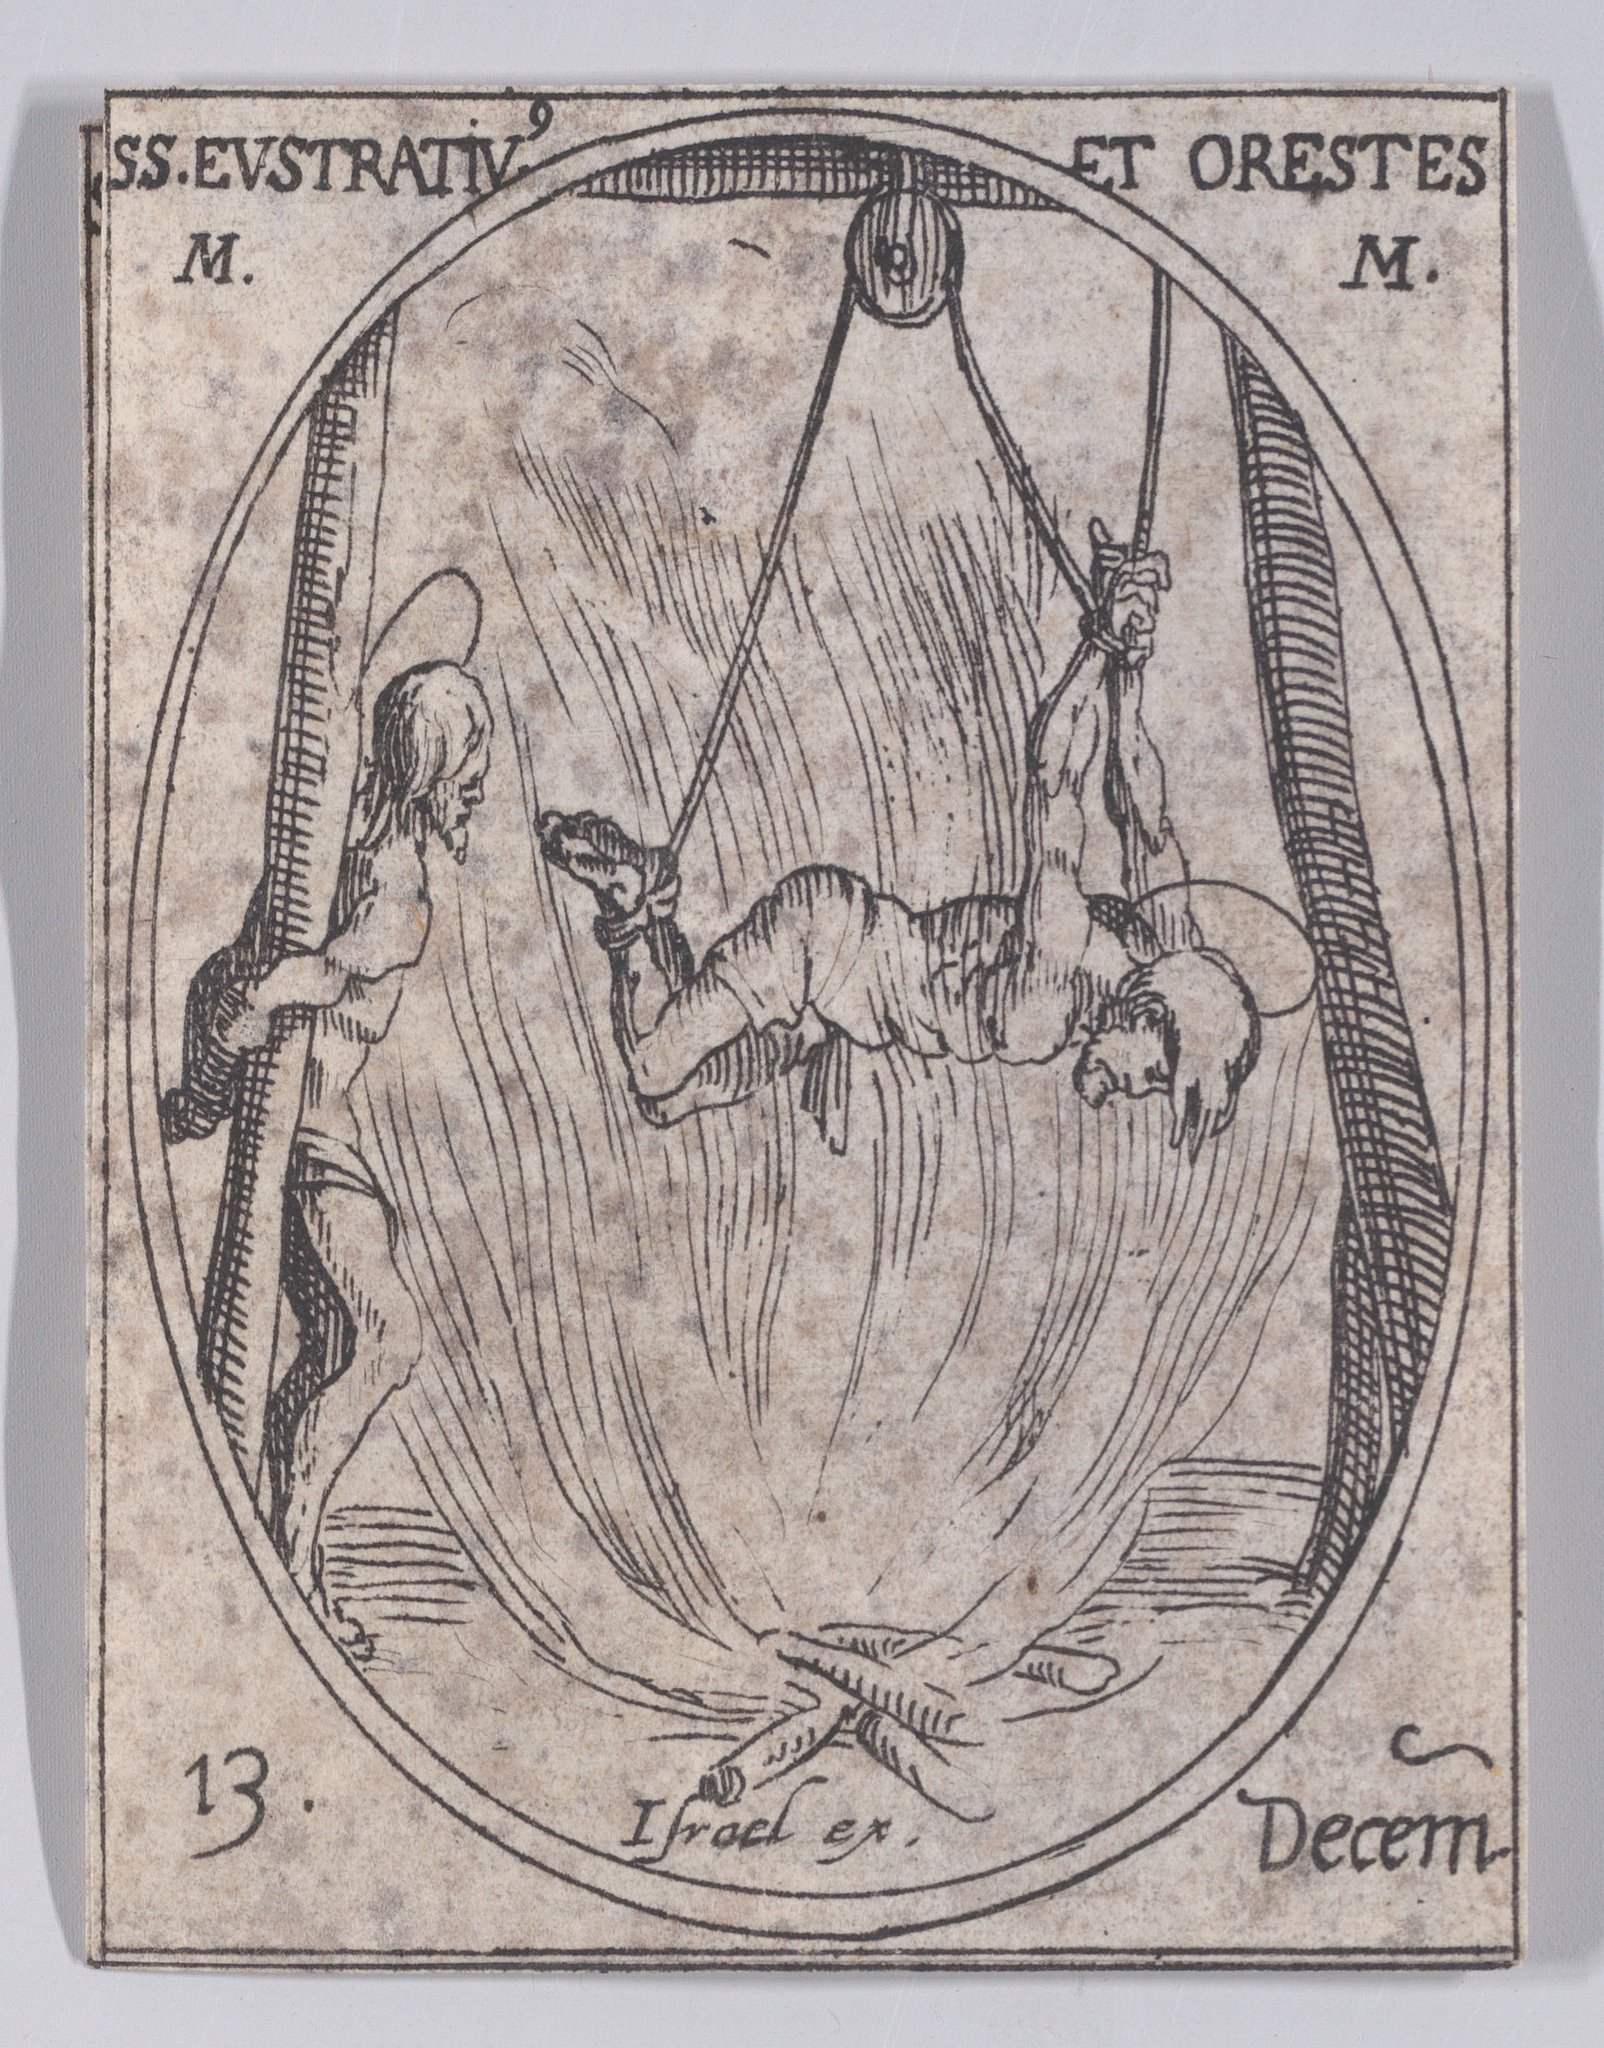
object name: print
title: S. Eustrate et S. Oreste (St. Eustratius and St. Orestes), December 13th, from "Les Images De Tous Les Saincts et Saintes de L'Année" (Images of All of the Saints and Religious Events of the Year)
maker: jacques callot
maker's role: artist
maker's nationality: french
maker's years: 1592-1635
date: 1636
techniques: etching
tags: men,fire,saints